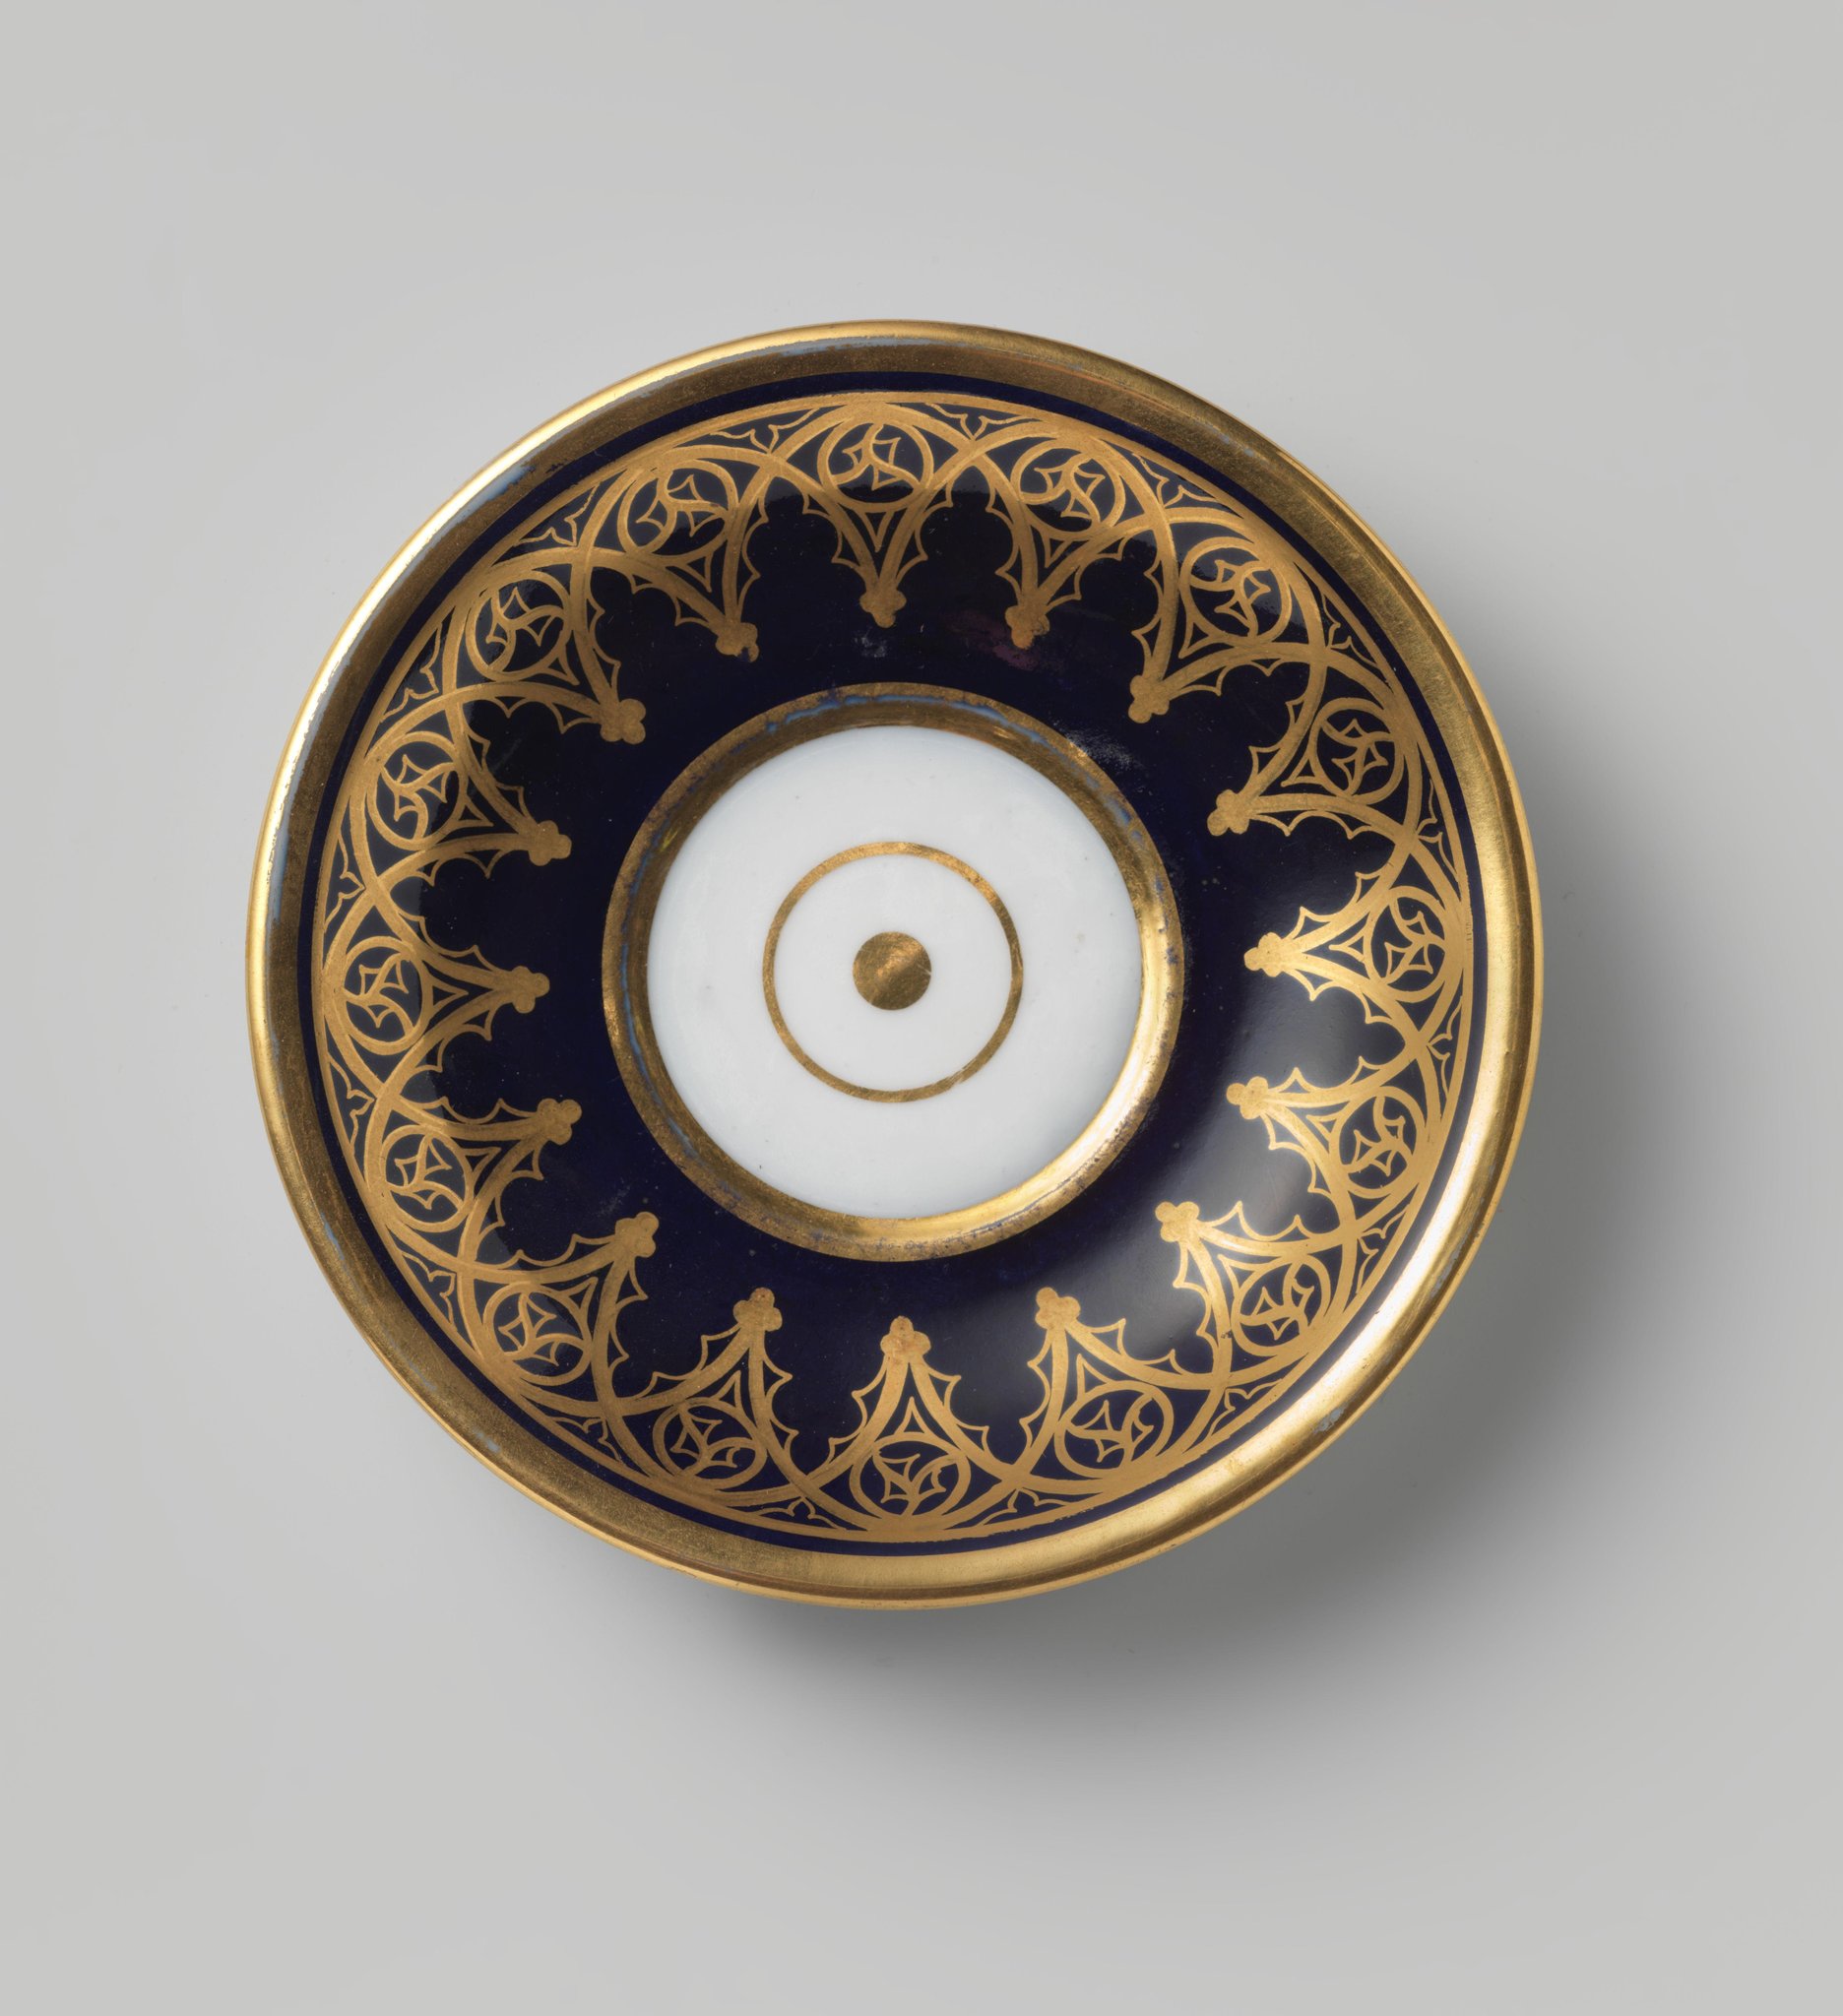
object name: platter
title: Saucer with a gothic arcade decoration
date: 1800-1899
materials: cobalt, glaze, gold, paint, porcelain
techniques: firing, forming, gilding, turning, vitrification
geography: saint-yrieix-la-perche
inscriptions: mark: ‘vis’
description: Schotel van porselein, deel van servies, beschilderd in goud op een koningsblauw fond met een arcademotief met gotische traceringen. Buiten dit decor en voor een groot deel aan de binnenzijde verguld. Gemerkt met een groen visje. Opmerking: zie voor merken ook het algemeen record.